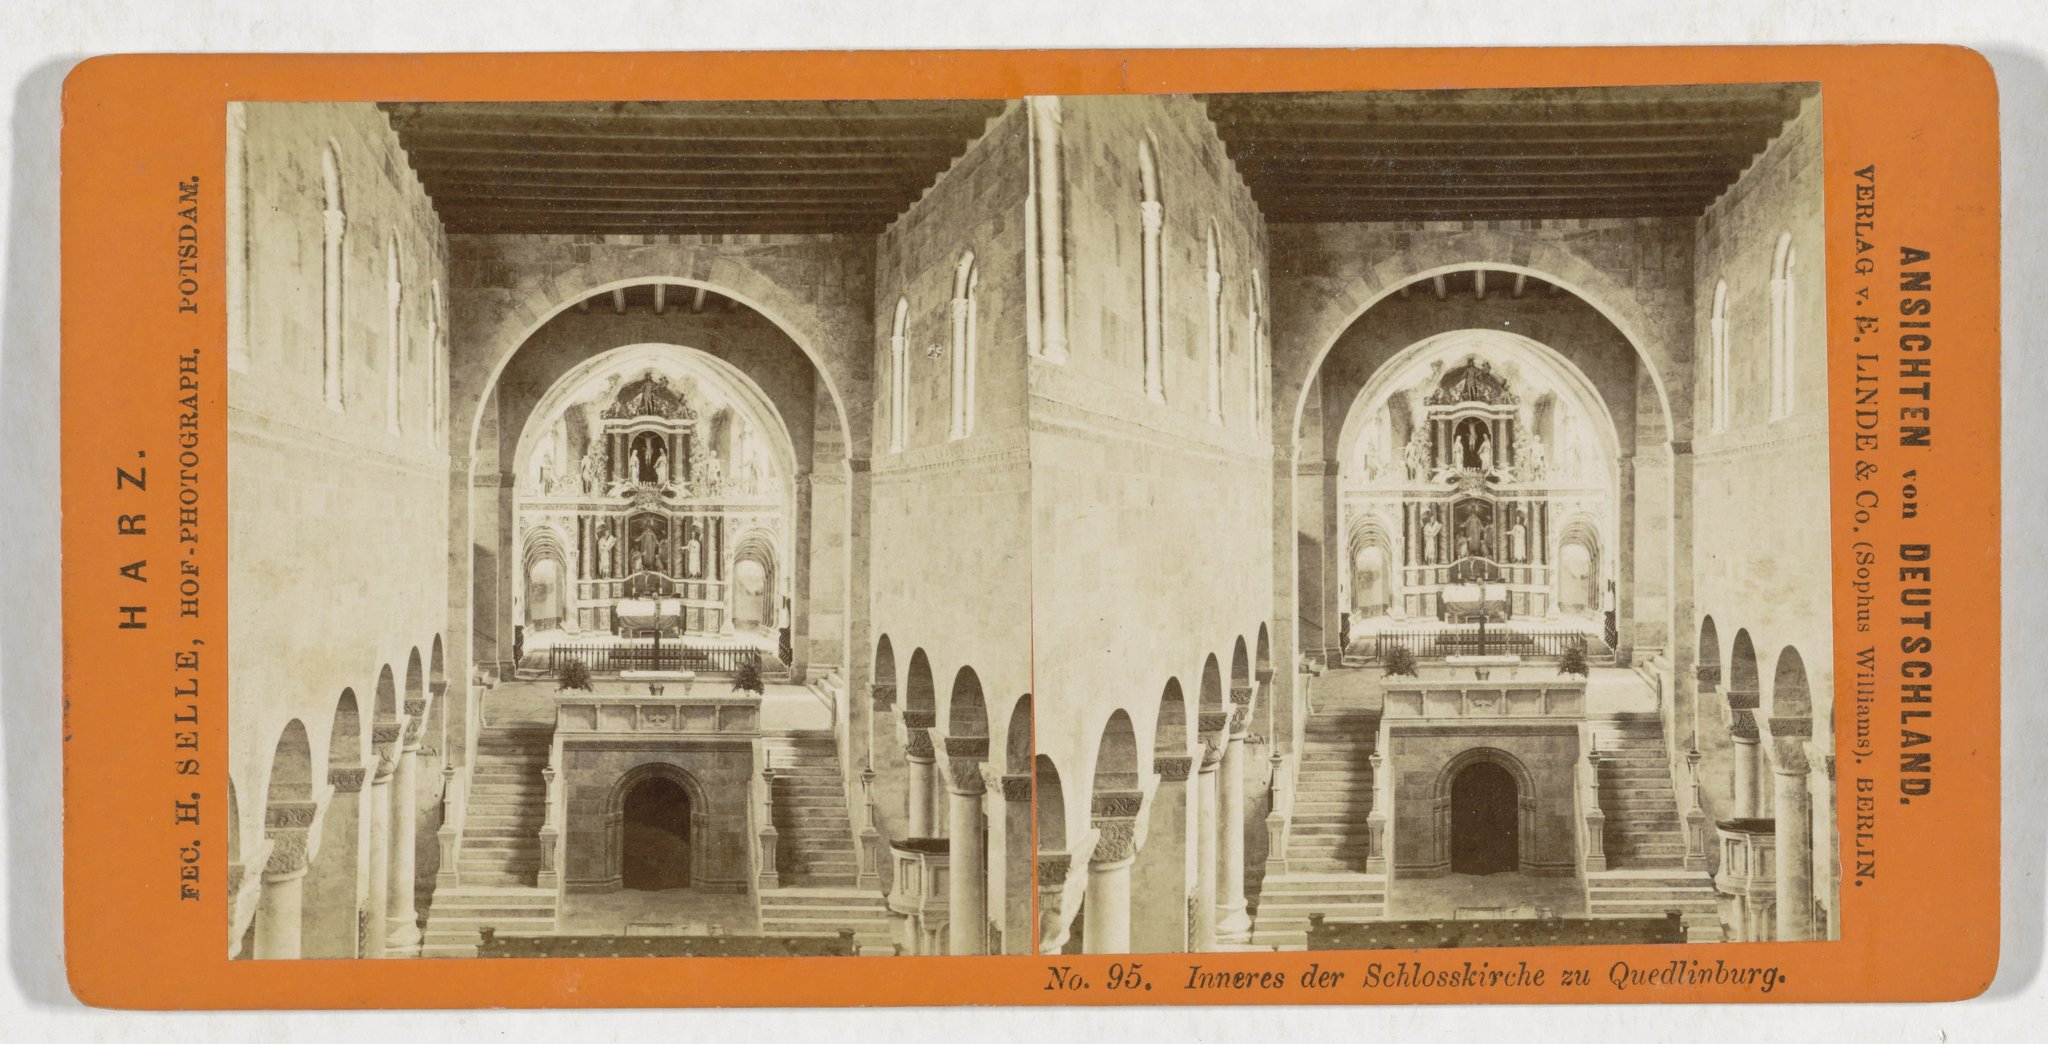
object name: stereograph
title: Ansichten von Deutschland / Harz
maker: hermann selle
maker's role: fotograaf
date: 1868-1890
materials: cardboard, paper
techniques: albumen print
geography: berlin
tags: interior of church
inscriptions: inscription: ‘Hof-Photograph. Potsdam.’, number: ‘No. 95.’